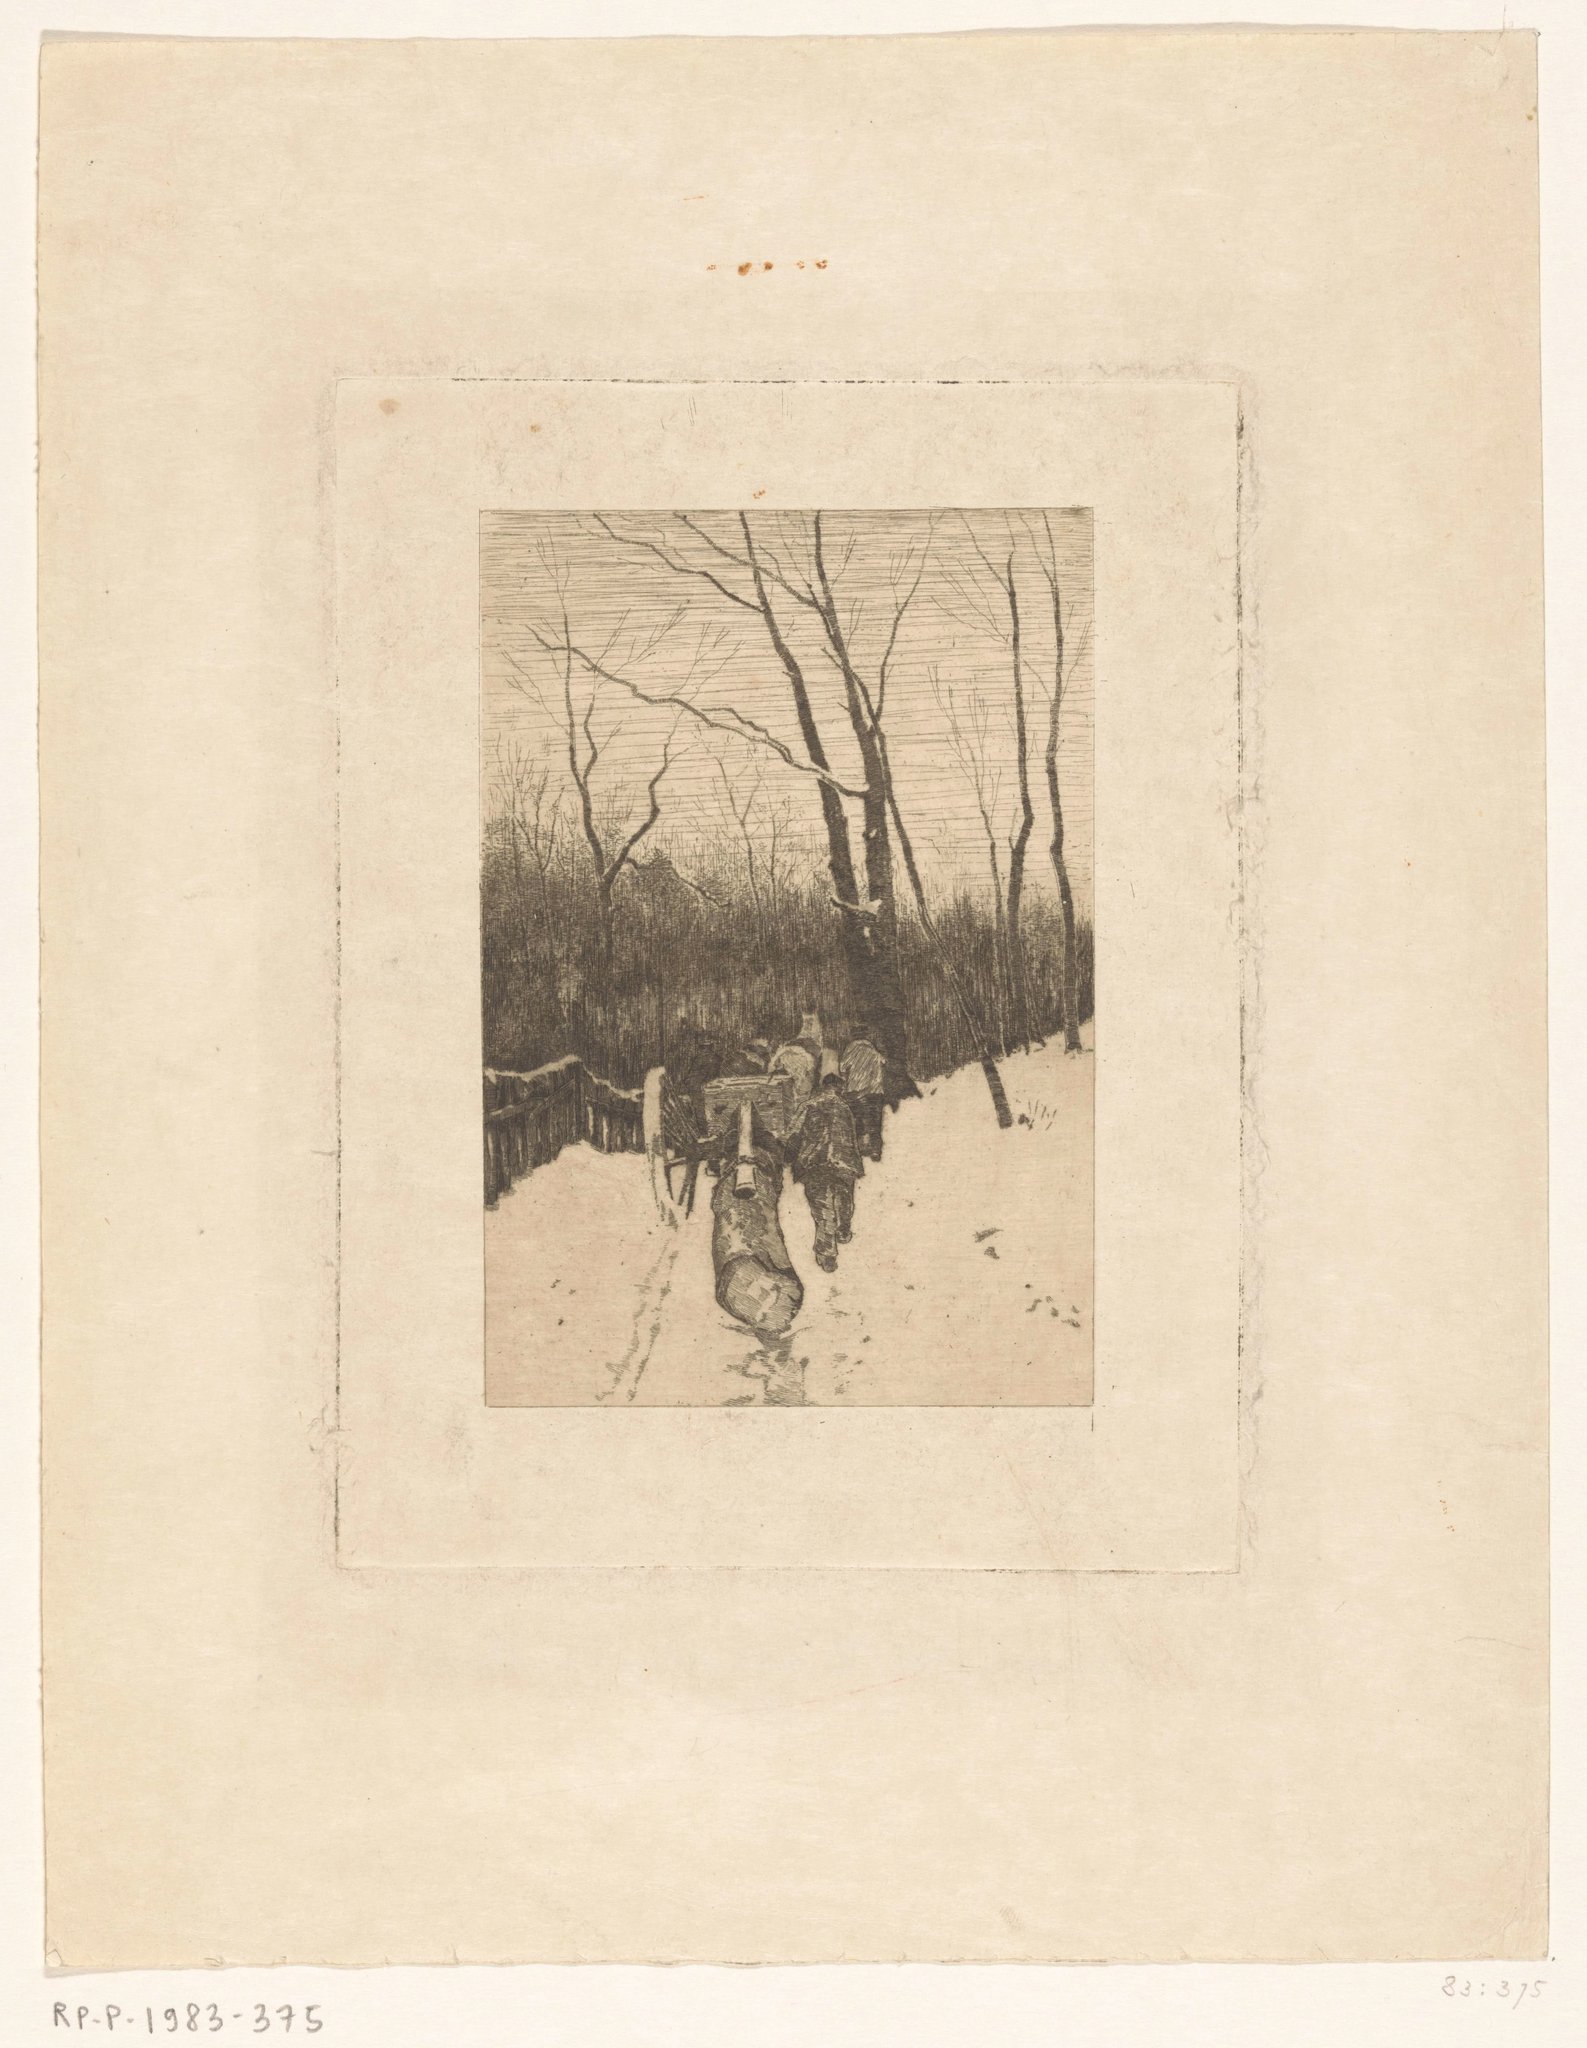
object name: print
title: Paarden die een boomstam voortslepen over een besneeuwd bospad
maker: richard nicolaüs roland holst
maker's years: 1868-1938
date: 1878-1938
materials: paper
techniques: etching, intaglio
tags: forestry, forest path or lane, snow, horse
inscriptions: inscription: ‘eigendom mevr. D. Klinkhamer-Bastert / Voert 3’, collector's mark: Lugt 2760, collector's mark: Lugt 2228